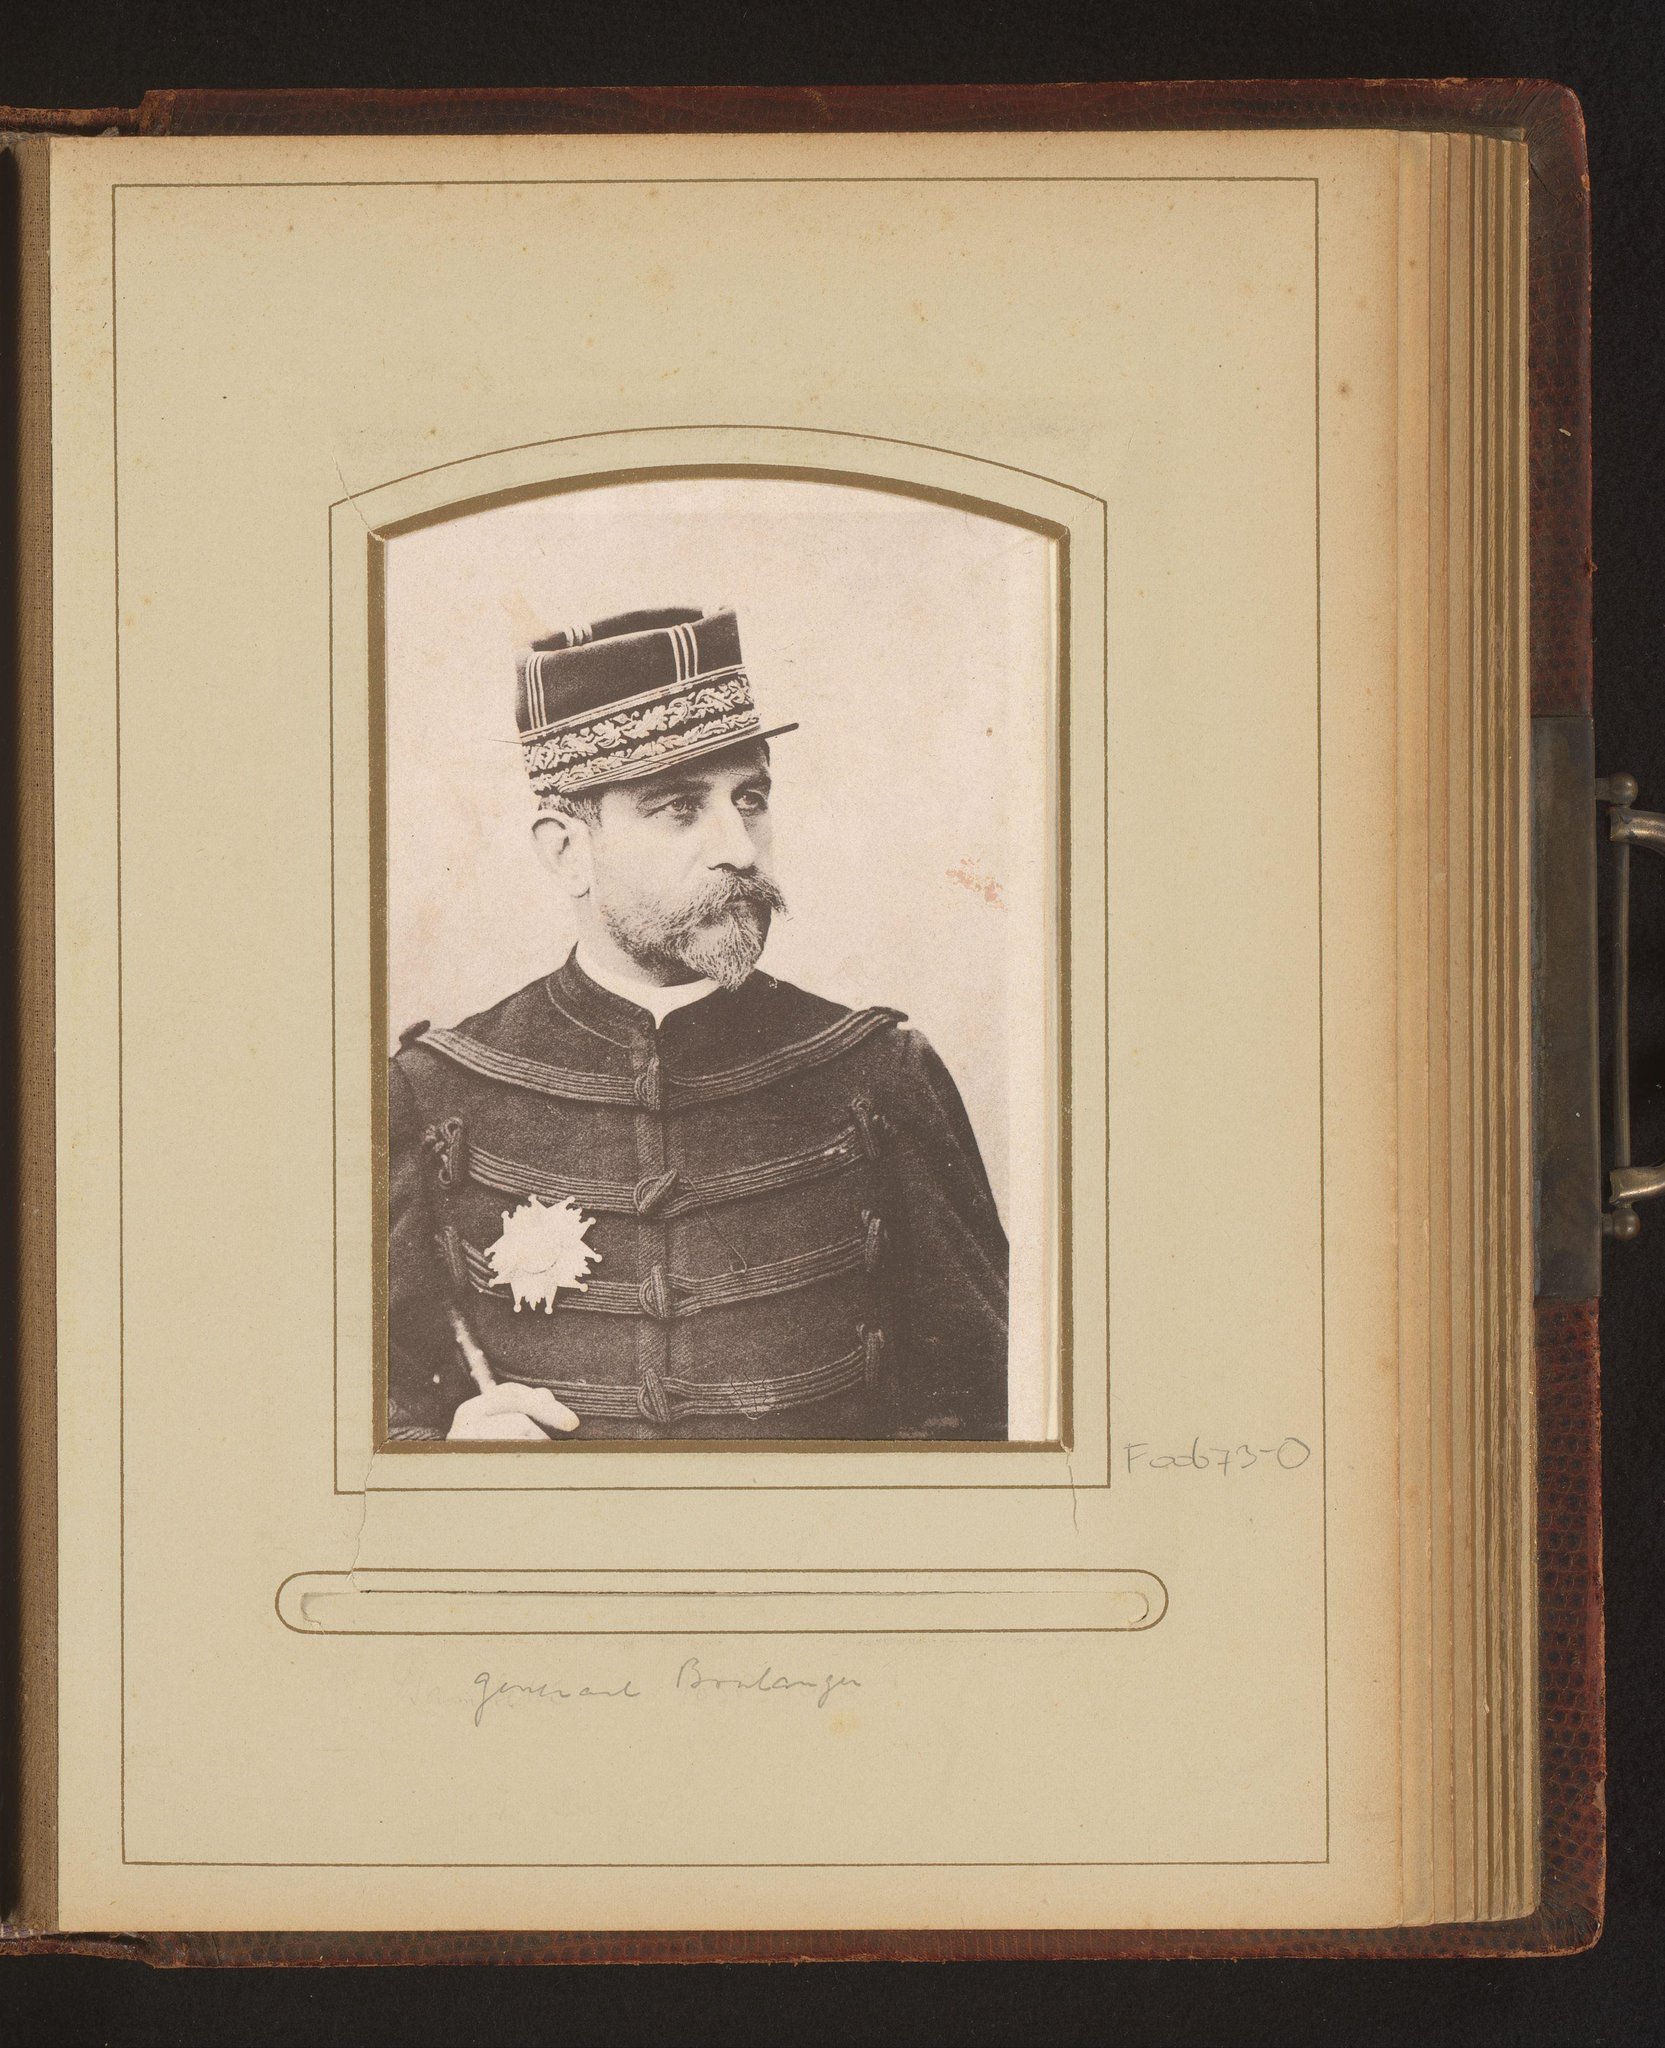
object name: cabinet photograph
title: Portret van generaal Georges Boulanger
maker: Anonymous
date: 1870-1890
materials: cardboard, photographic support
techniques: photograph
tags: commander-in-chief, general, marshal, historical persons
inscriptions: annotation: ‘General Boulanger’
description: Deze prent maakt deel uit van een album.